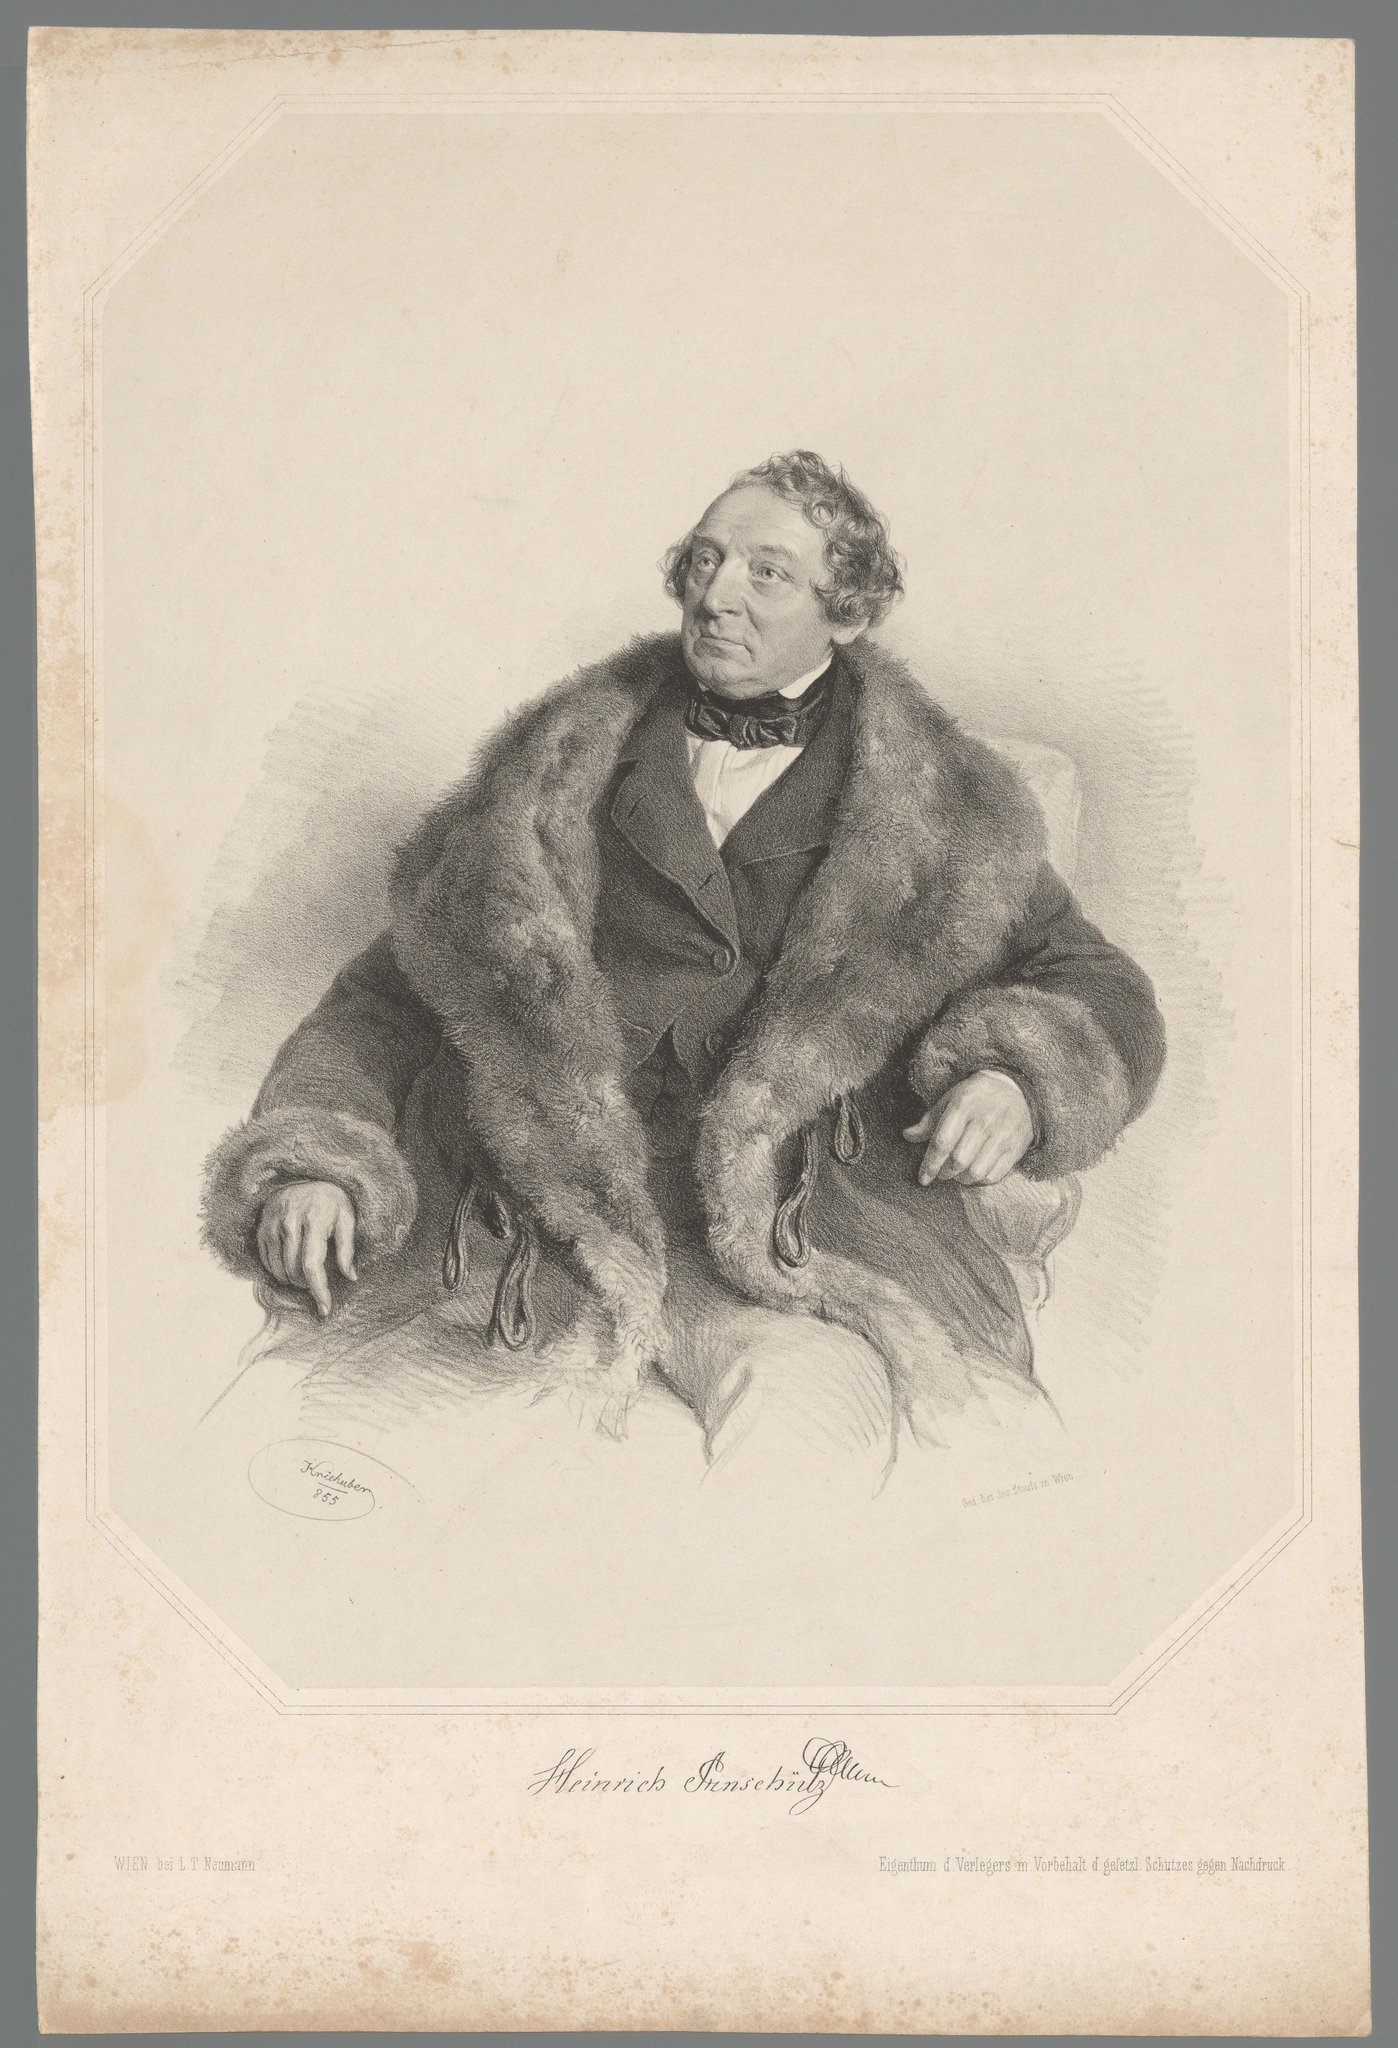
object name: print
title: Portret van Heinrich Anschütz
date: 1855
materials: paper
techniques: lithograph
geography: vienna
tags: vienna, historical persons, portrait of actor, actress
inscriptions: collector's mark: Lugt 2228